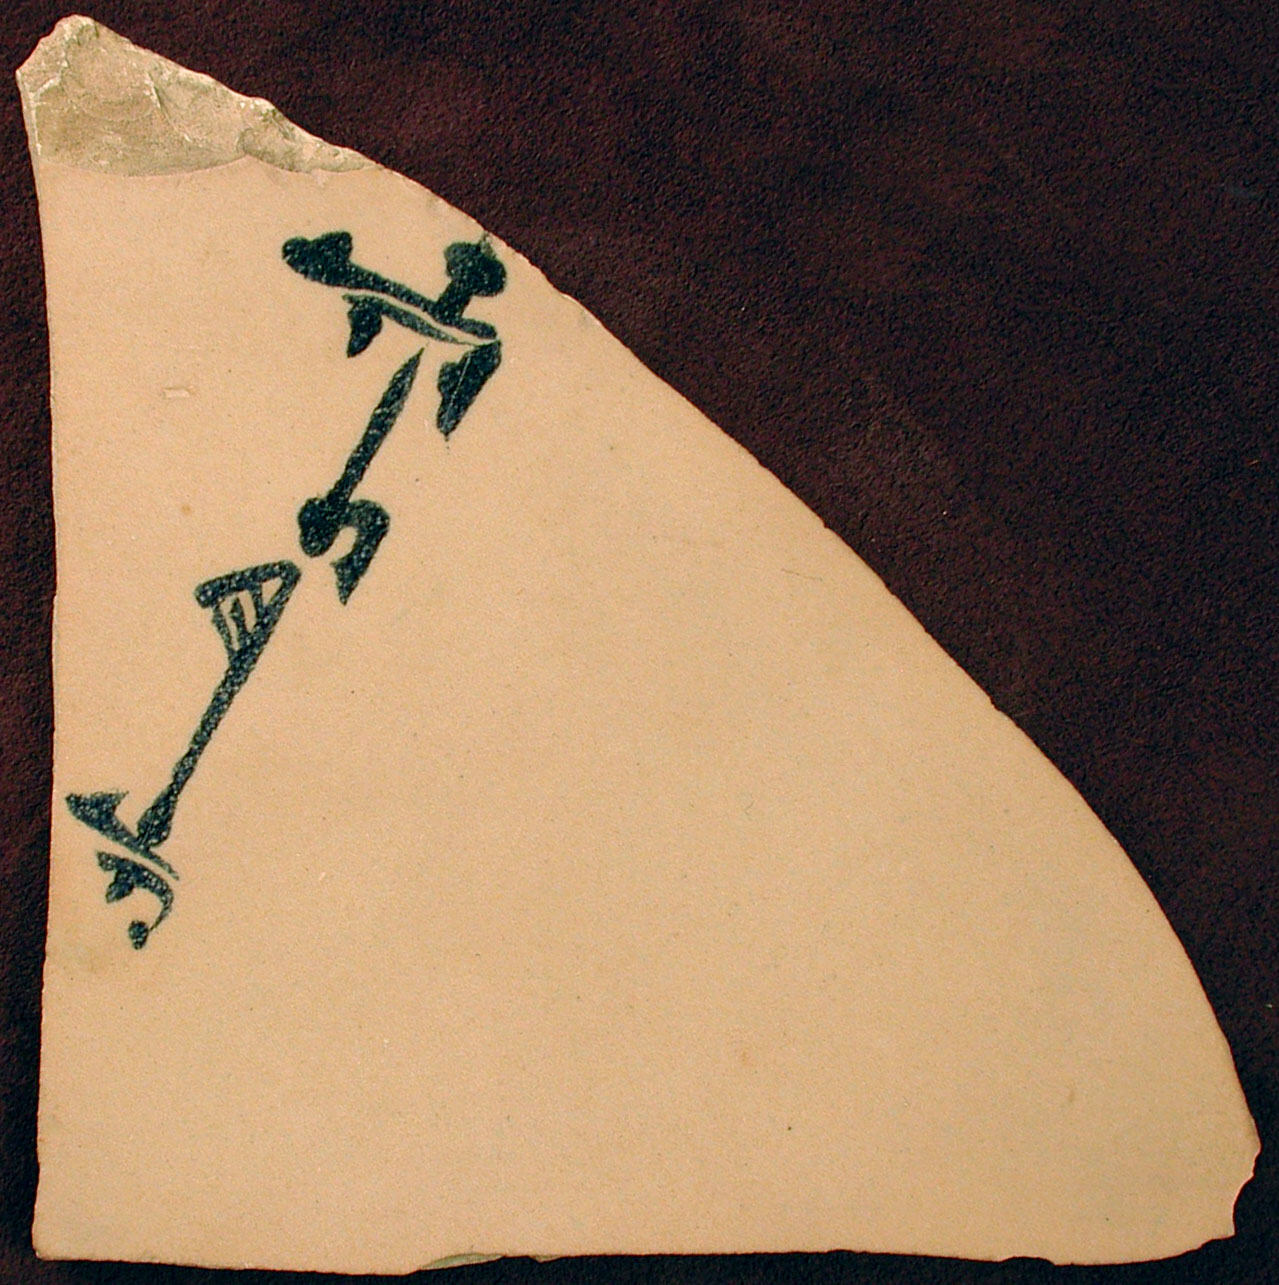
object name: fragment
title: Ceramic Fragment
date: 801-900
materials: earthenware, glaze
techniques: painting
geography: iraq